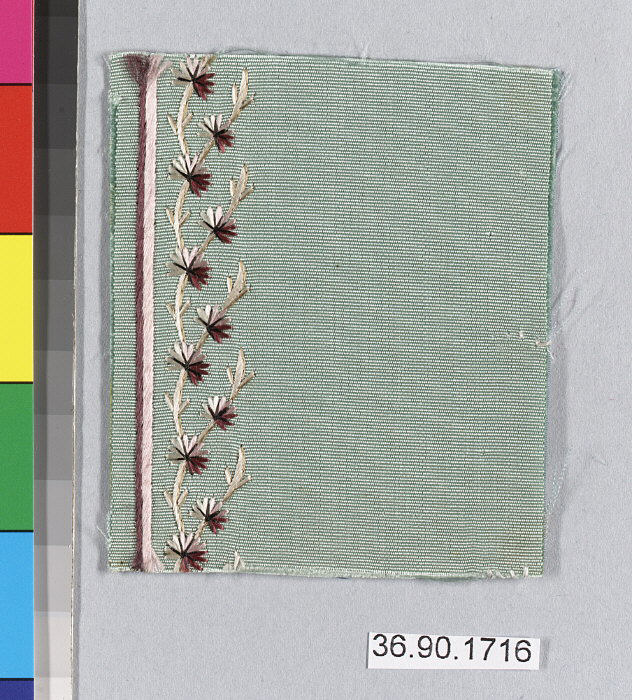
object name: sample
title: Embroidery sample for a man’s suit or waistcoat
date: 1785-1815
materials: silk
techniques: embroidery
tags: flowers